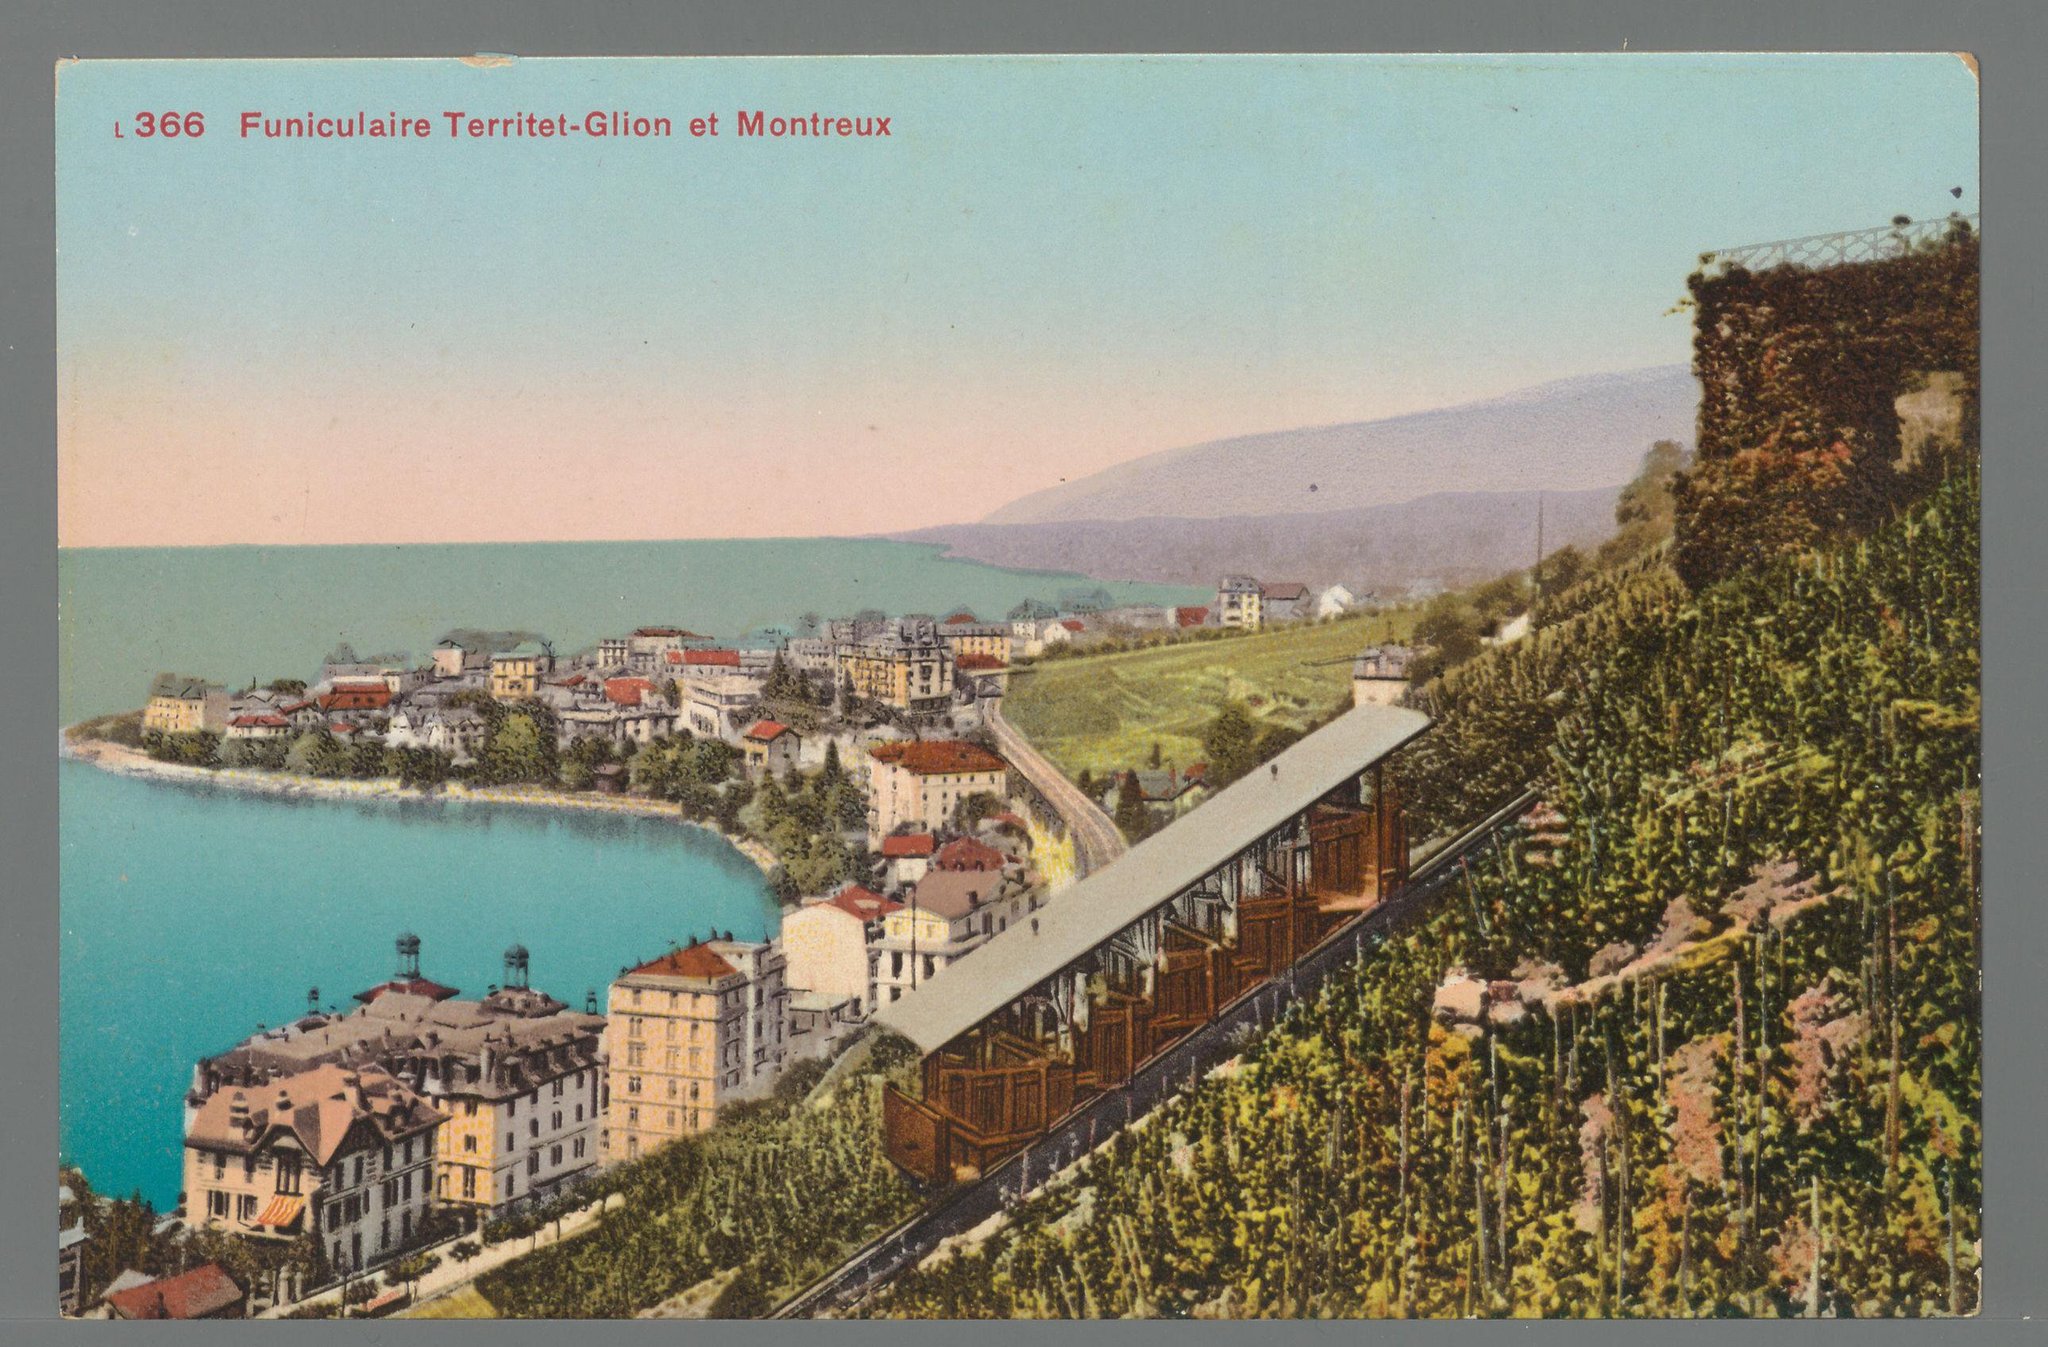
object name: photomechanical print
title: Funiculaire Territet-Glion et Montreux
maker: Anonymous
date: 1905-1920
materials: cardboard, photographic process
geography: zurich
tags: funicular railway, lake, prospect of city, town panorama, silhouette of city